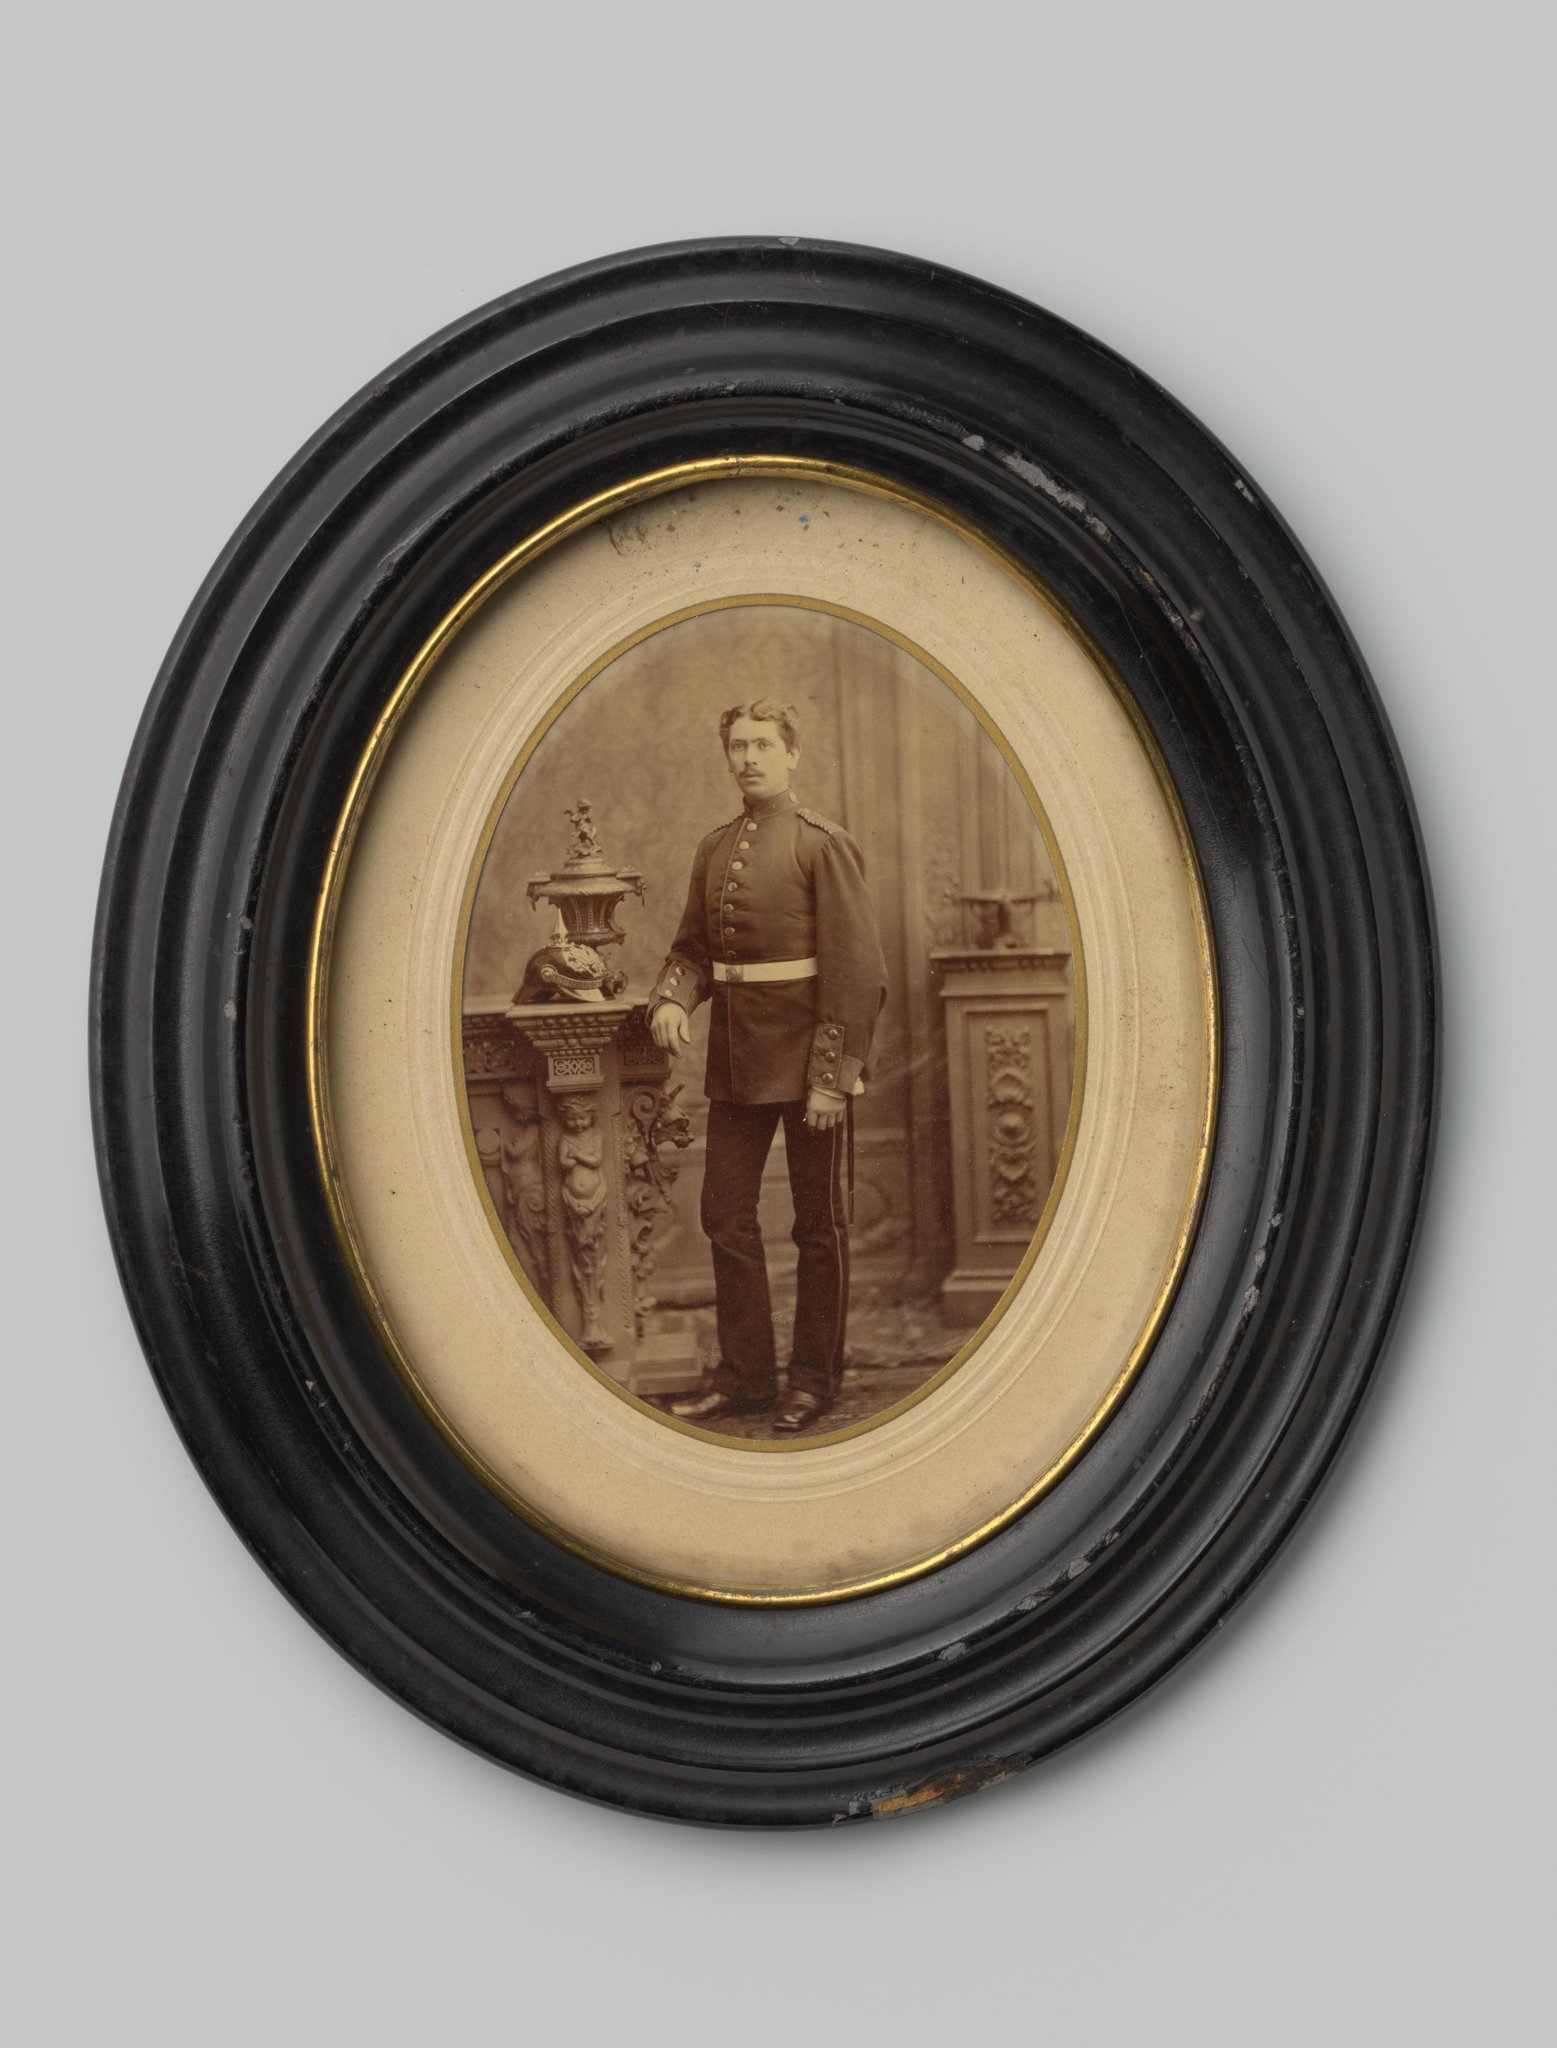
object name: frame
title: Portret van een onbekende staande man in militair uniform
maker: Anonymous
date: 1880-1900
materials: cardboard, glass, metal, paper, wood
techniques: albumen print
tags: adult man, anonymous historical person portrayed